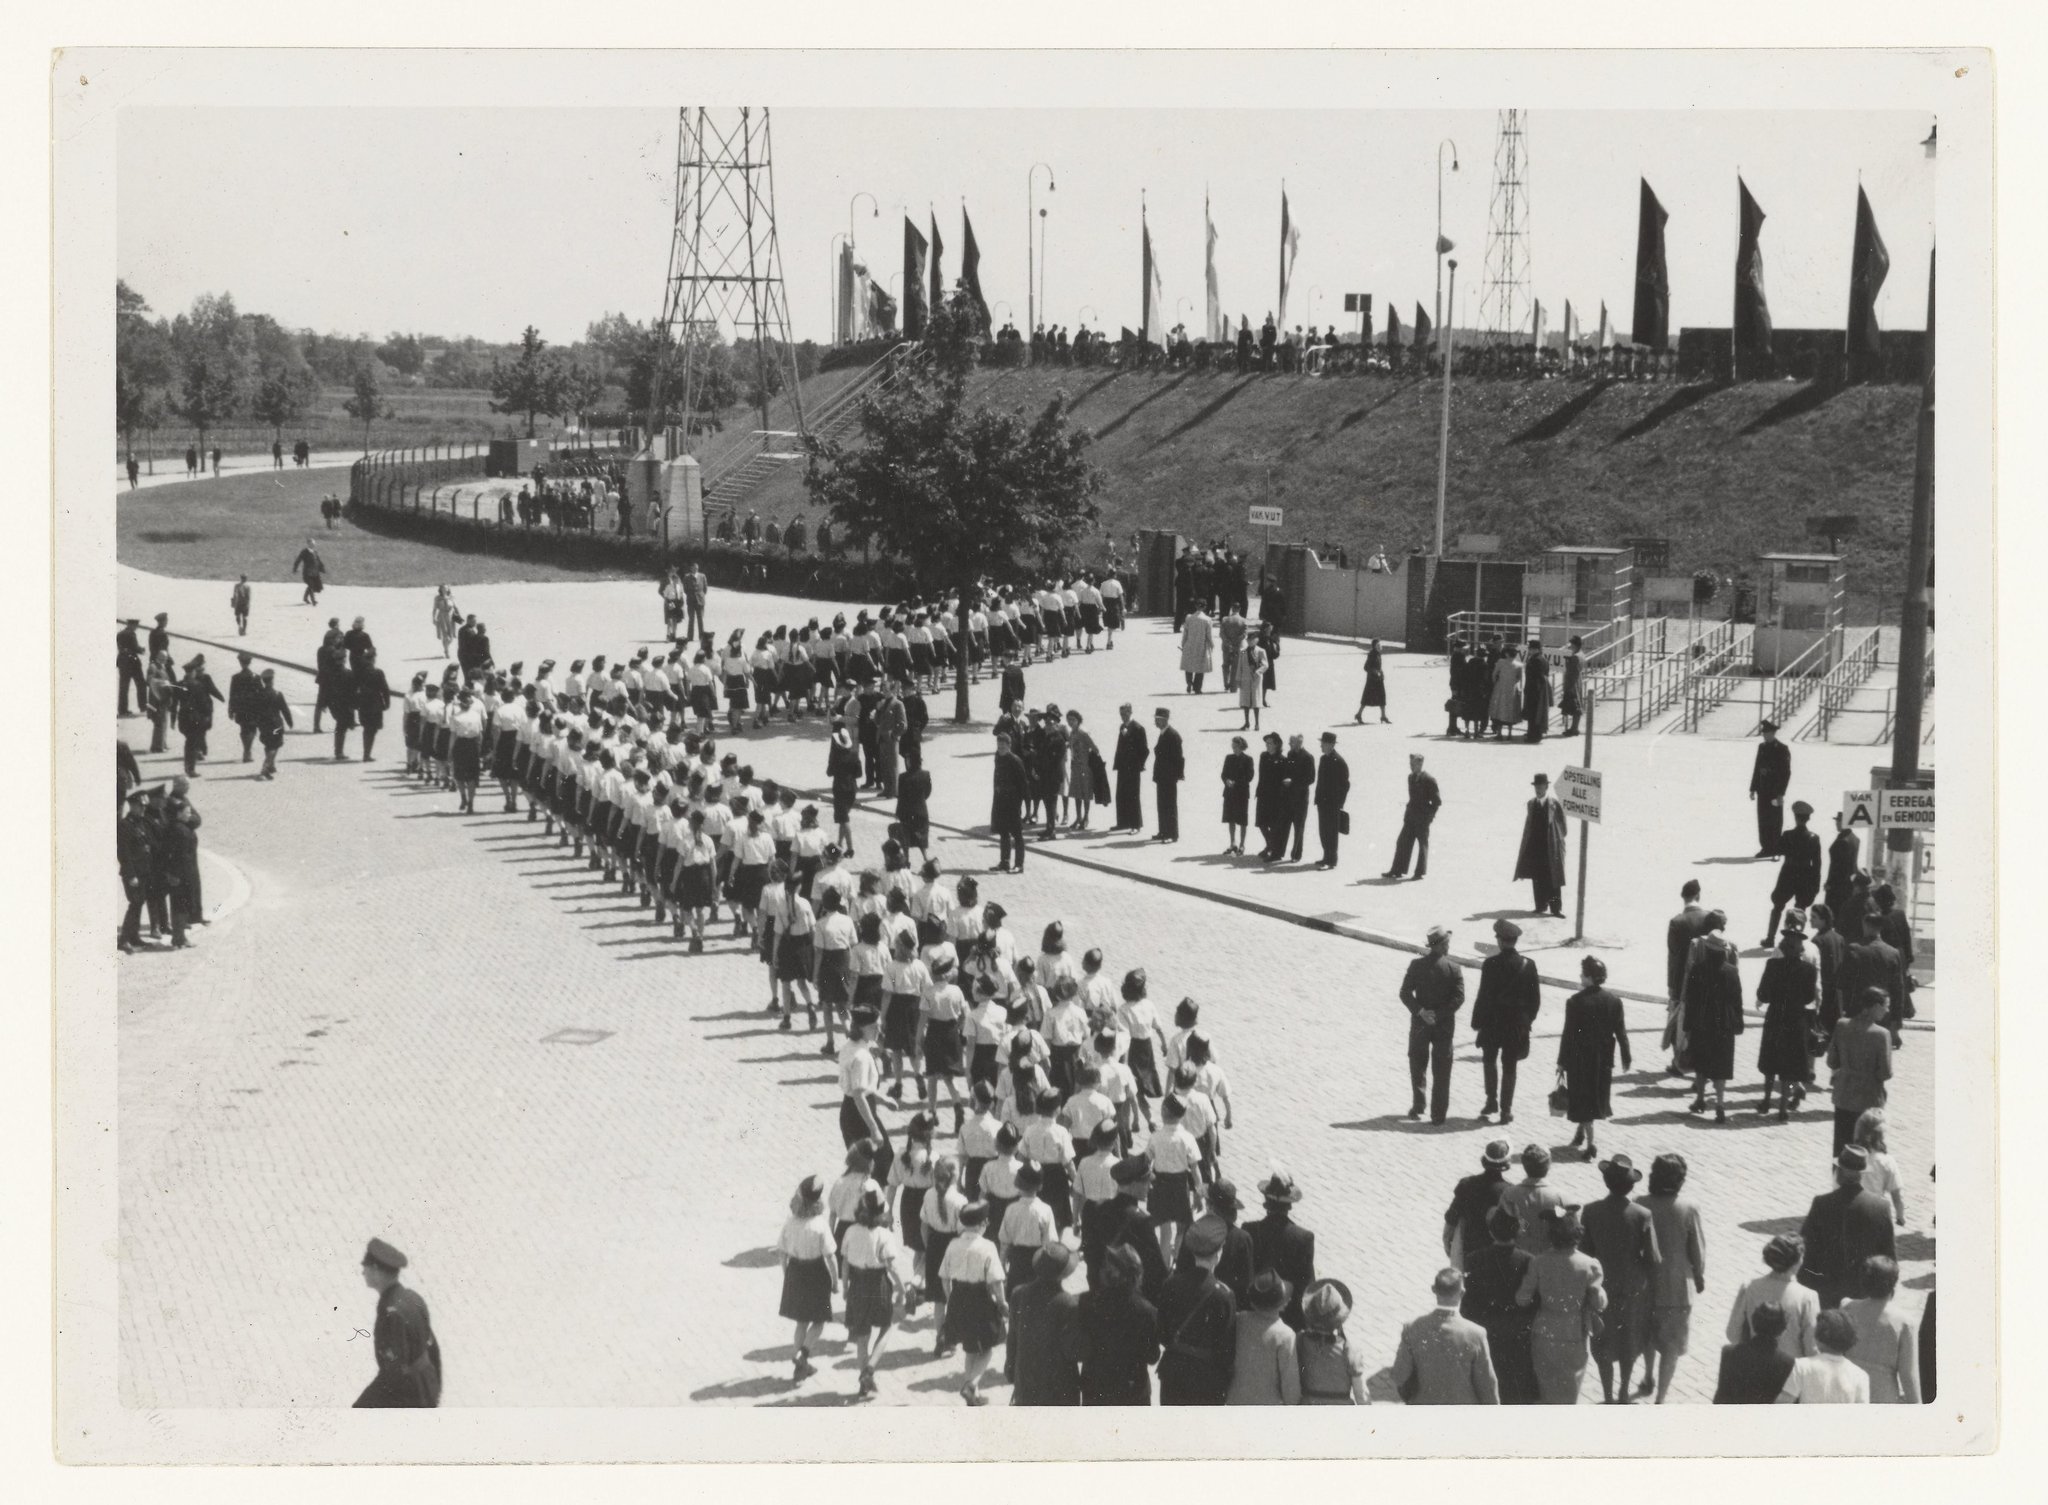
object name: photograph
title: Jeugdstorm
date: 1942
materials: photographic support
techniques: photography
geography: utrecht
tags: the hague, politician, anton adriaan mussert, military parade, pageant, utrecht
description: Een lange rij leden van de Jeugdstorm staat bij de ingang van het Stadion Galgenwaard in Utrecht op 20 juni 1942. In het stadion zullen zij de beëdiging van 3000 kaderleden van de NSB bijwonen. De ceremonie van de eedsaflegging was het gevolg van een compromis tussen de Duitsers en de NSB. De Duitsers wilden een eed op Hitler (wat Mussert stiekem enigte tijd daarvoor had gedaan) de NSB niet. Compromis: Nederlandse SSers legden de eed op Hitler af, kaderleden van de NSB op Mussert.